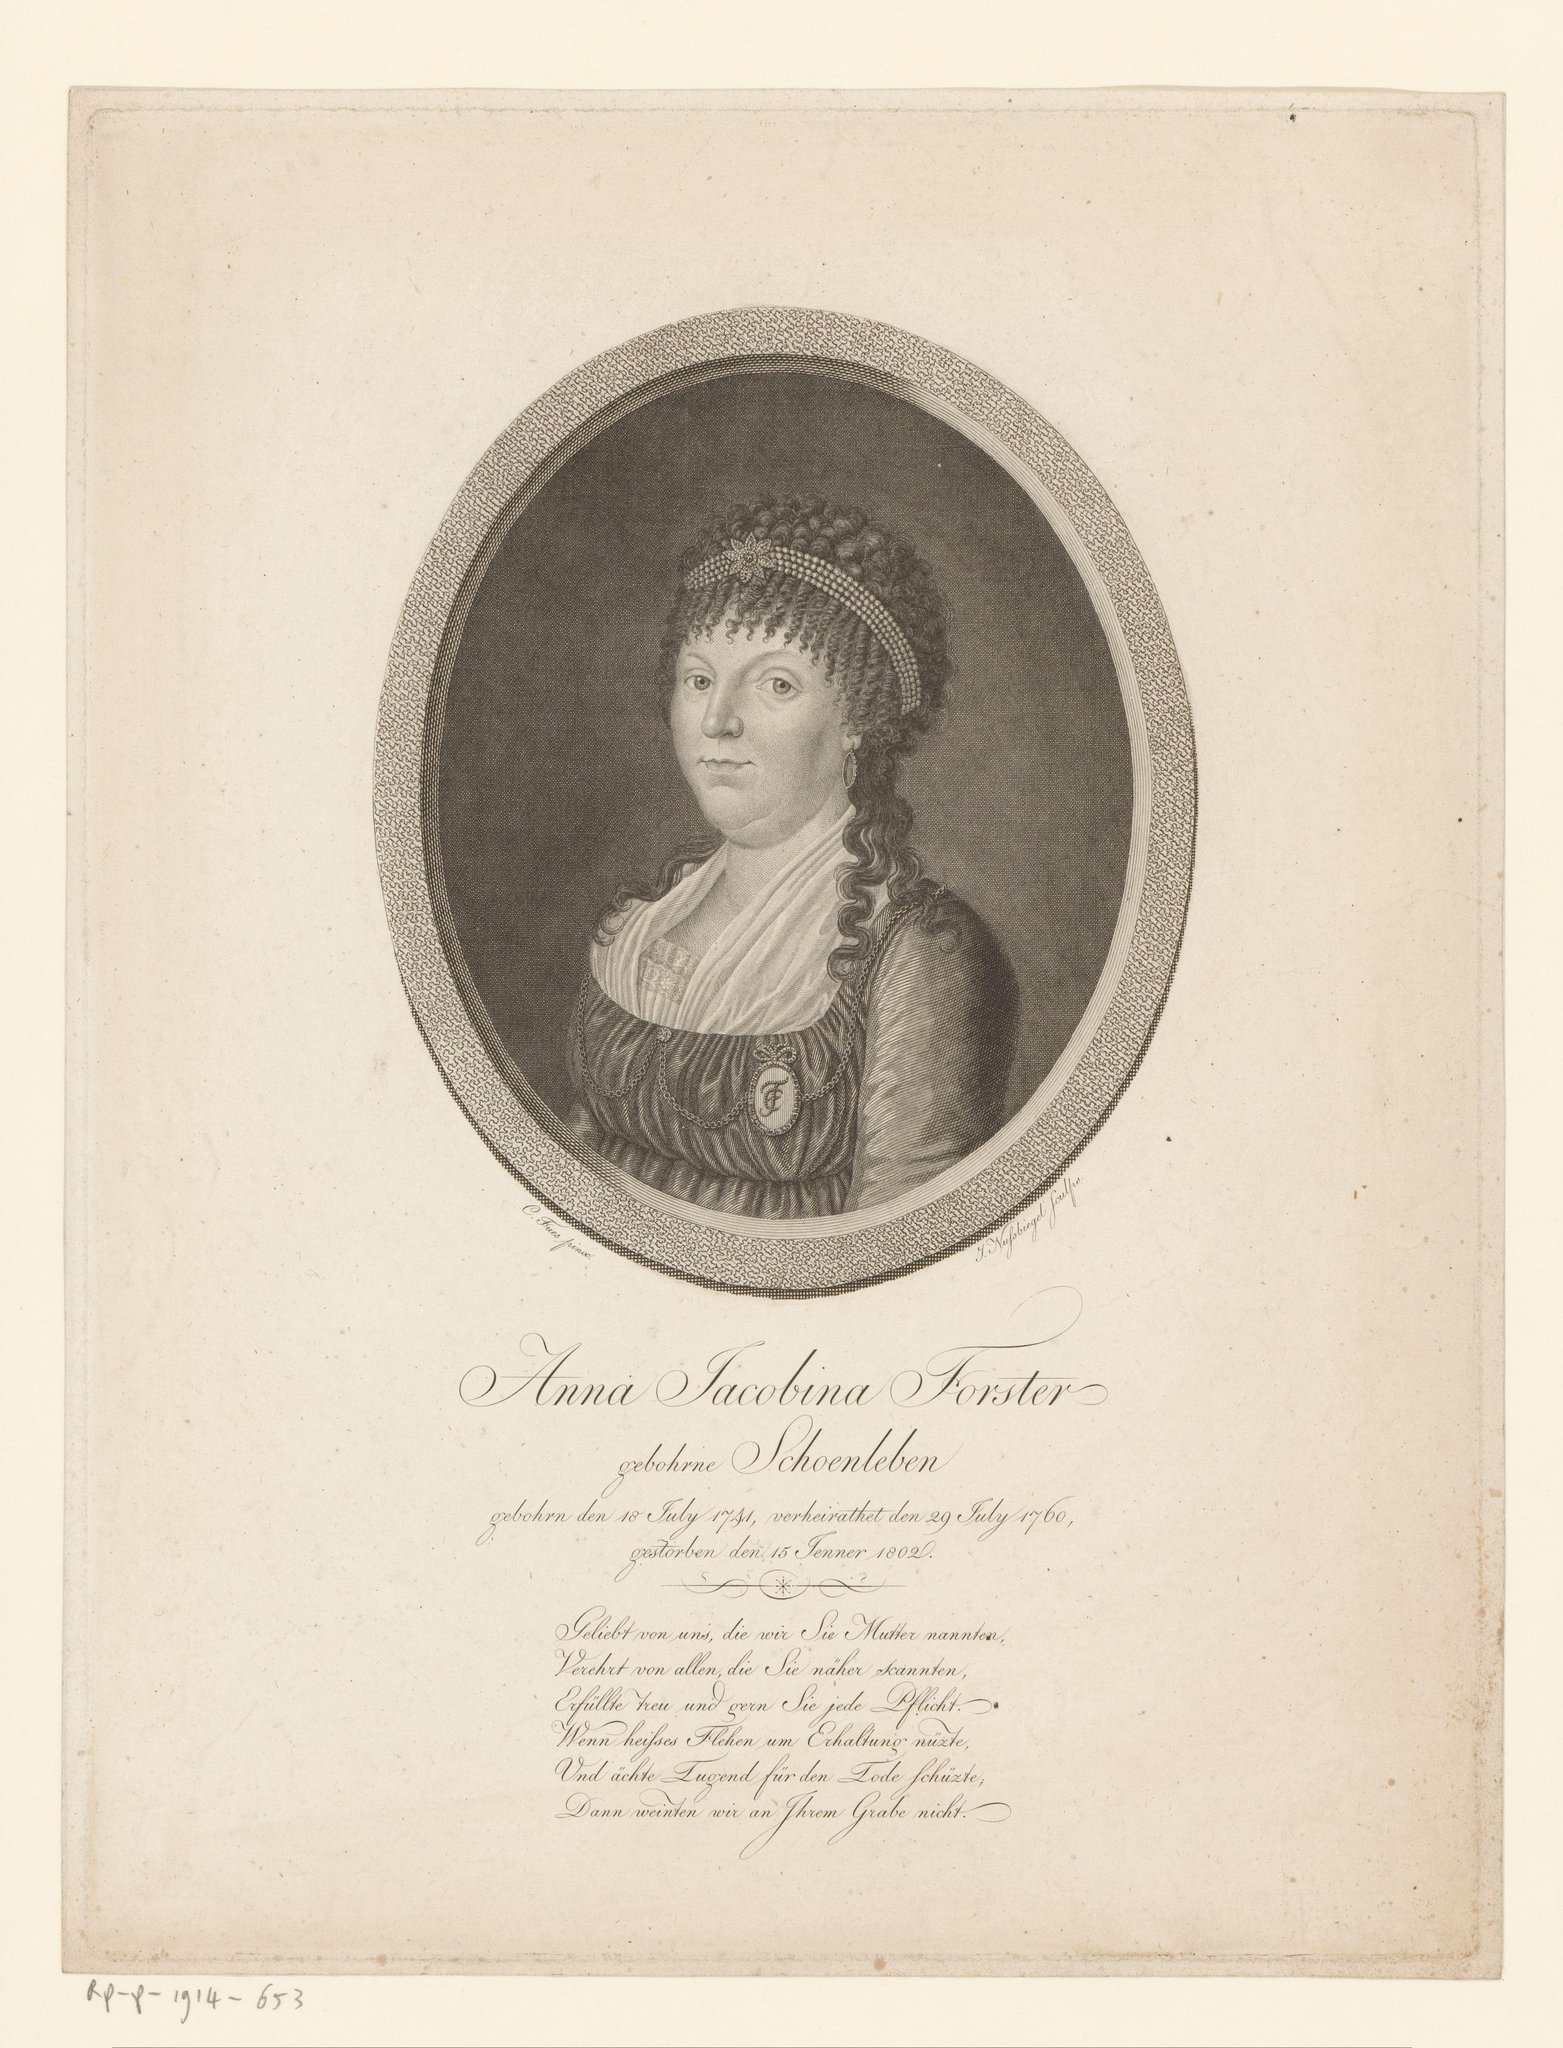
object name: print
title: Portret van Anna Jacobina Forster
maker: johann nusbiegel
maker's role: print maker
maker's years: 1750-1829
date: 1802-1829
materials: paper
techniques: engraving, etching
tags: historical persons - bb - woman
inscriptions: collector's mark: Lugt 2228